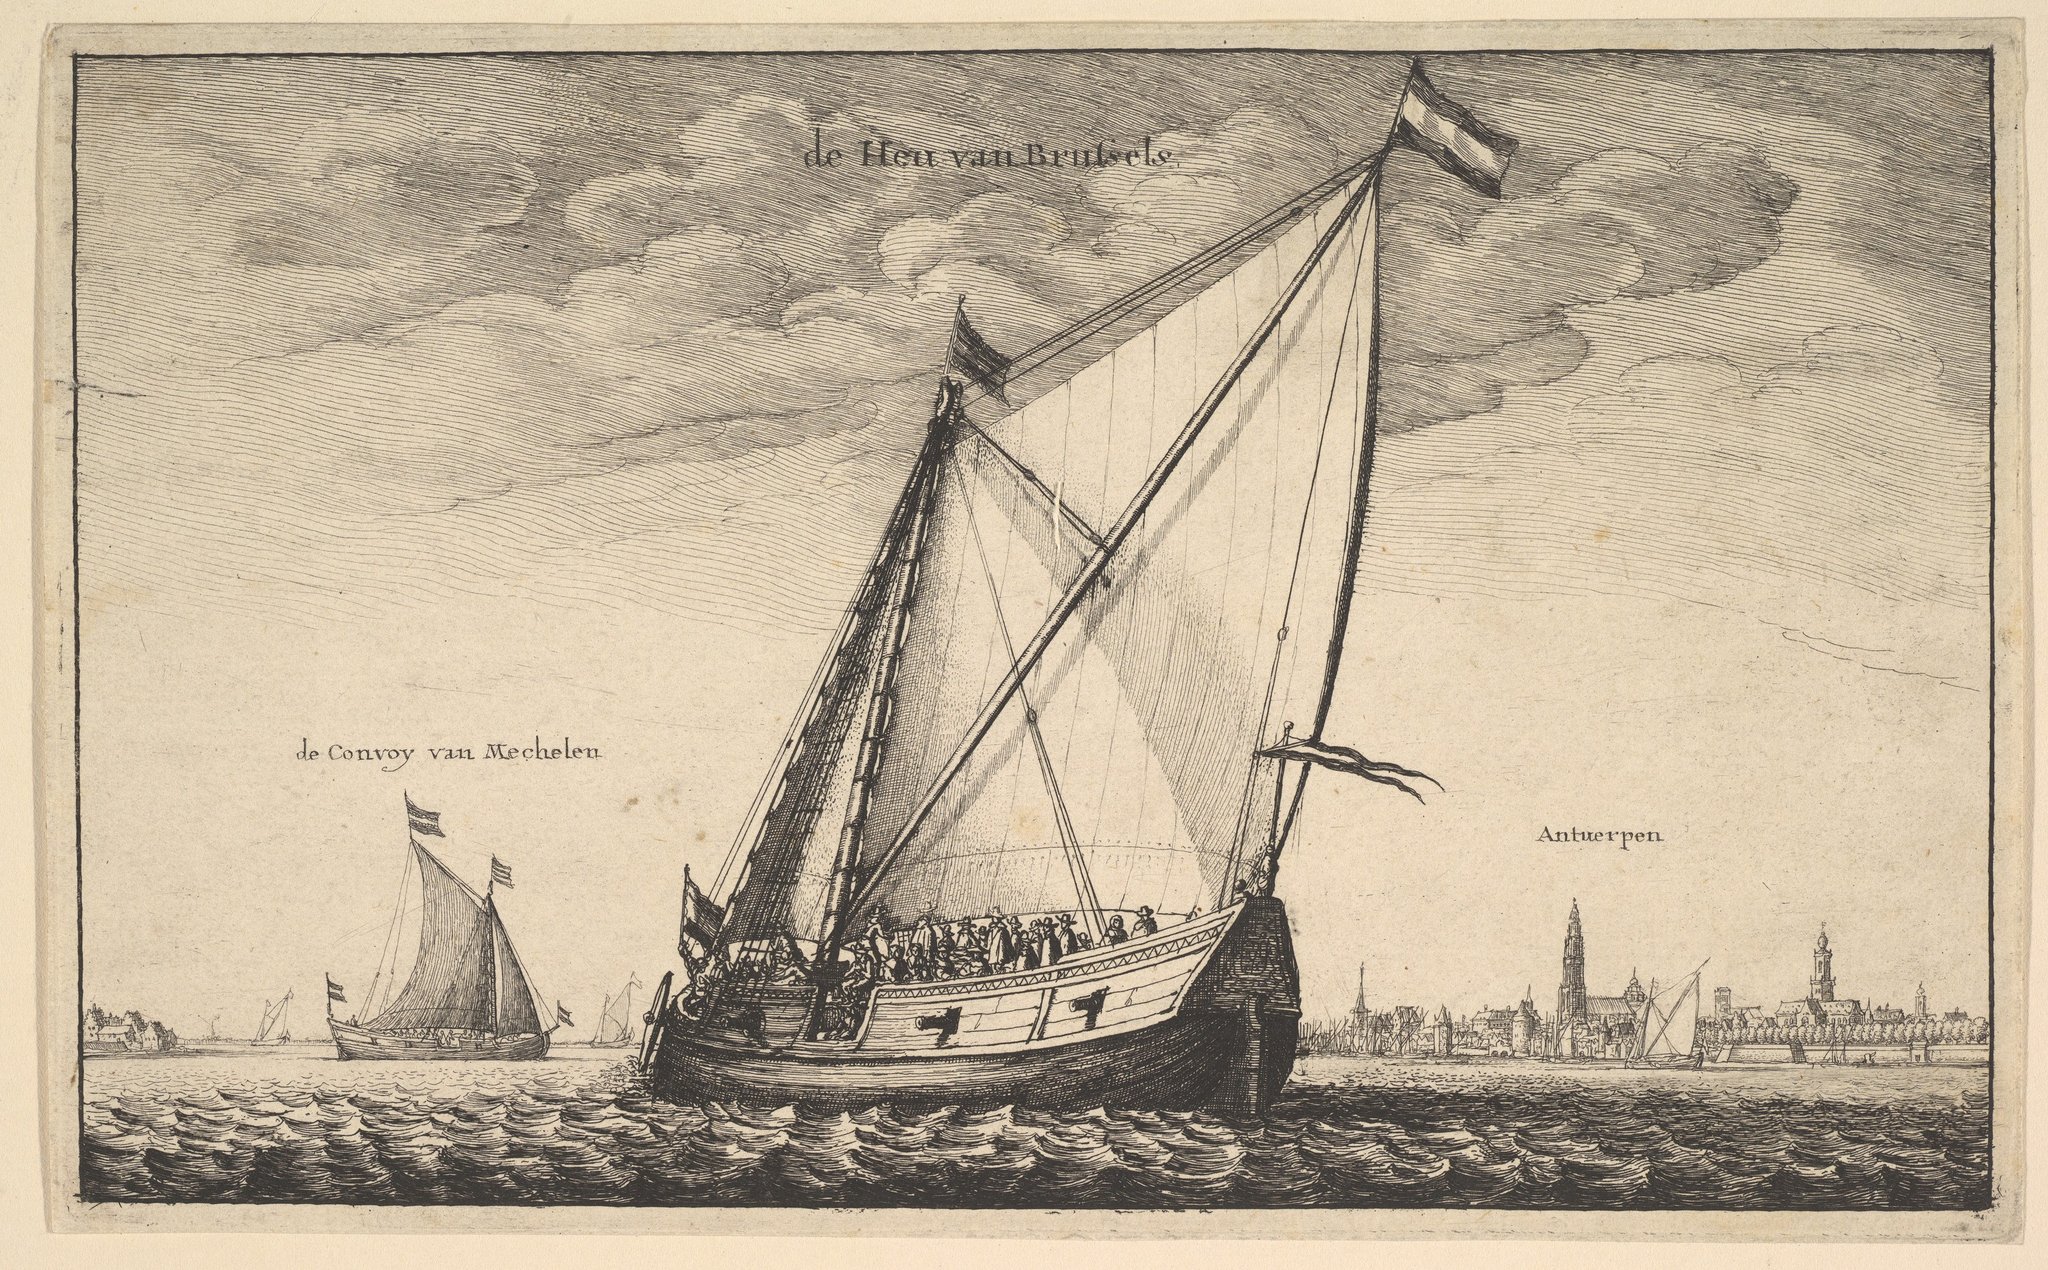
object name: print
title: The Brussels Packet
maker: wenceslaus hollar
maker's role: artist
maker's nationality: bohemian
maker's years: 1607-1677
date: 1625-1677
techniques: etching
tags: ships